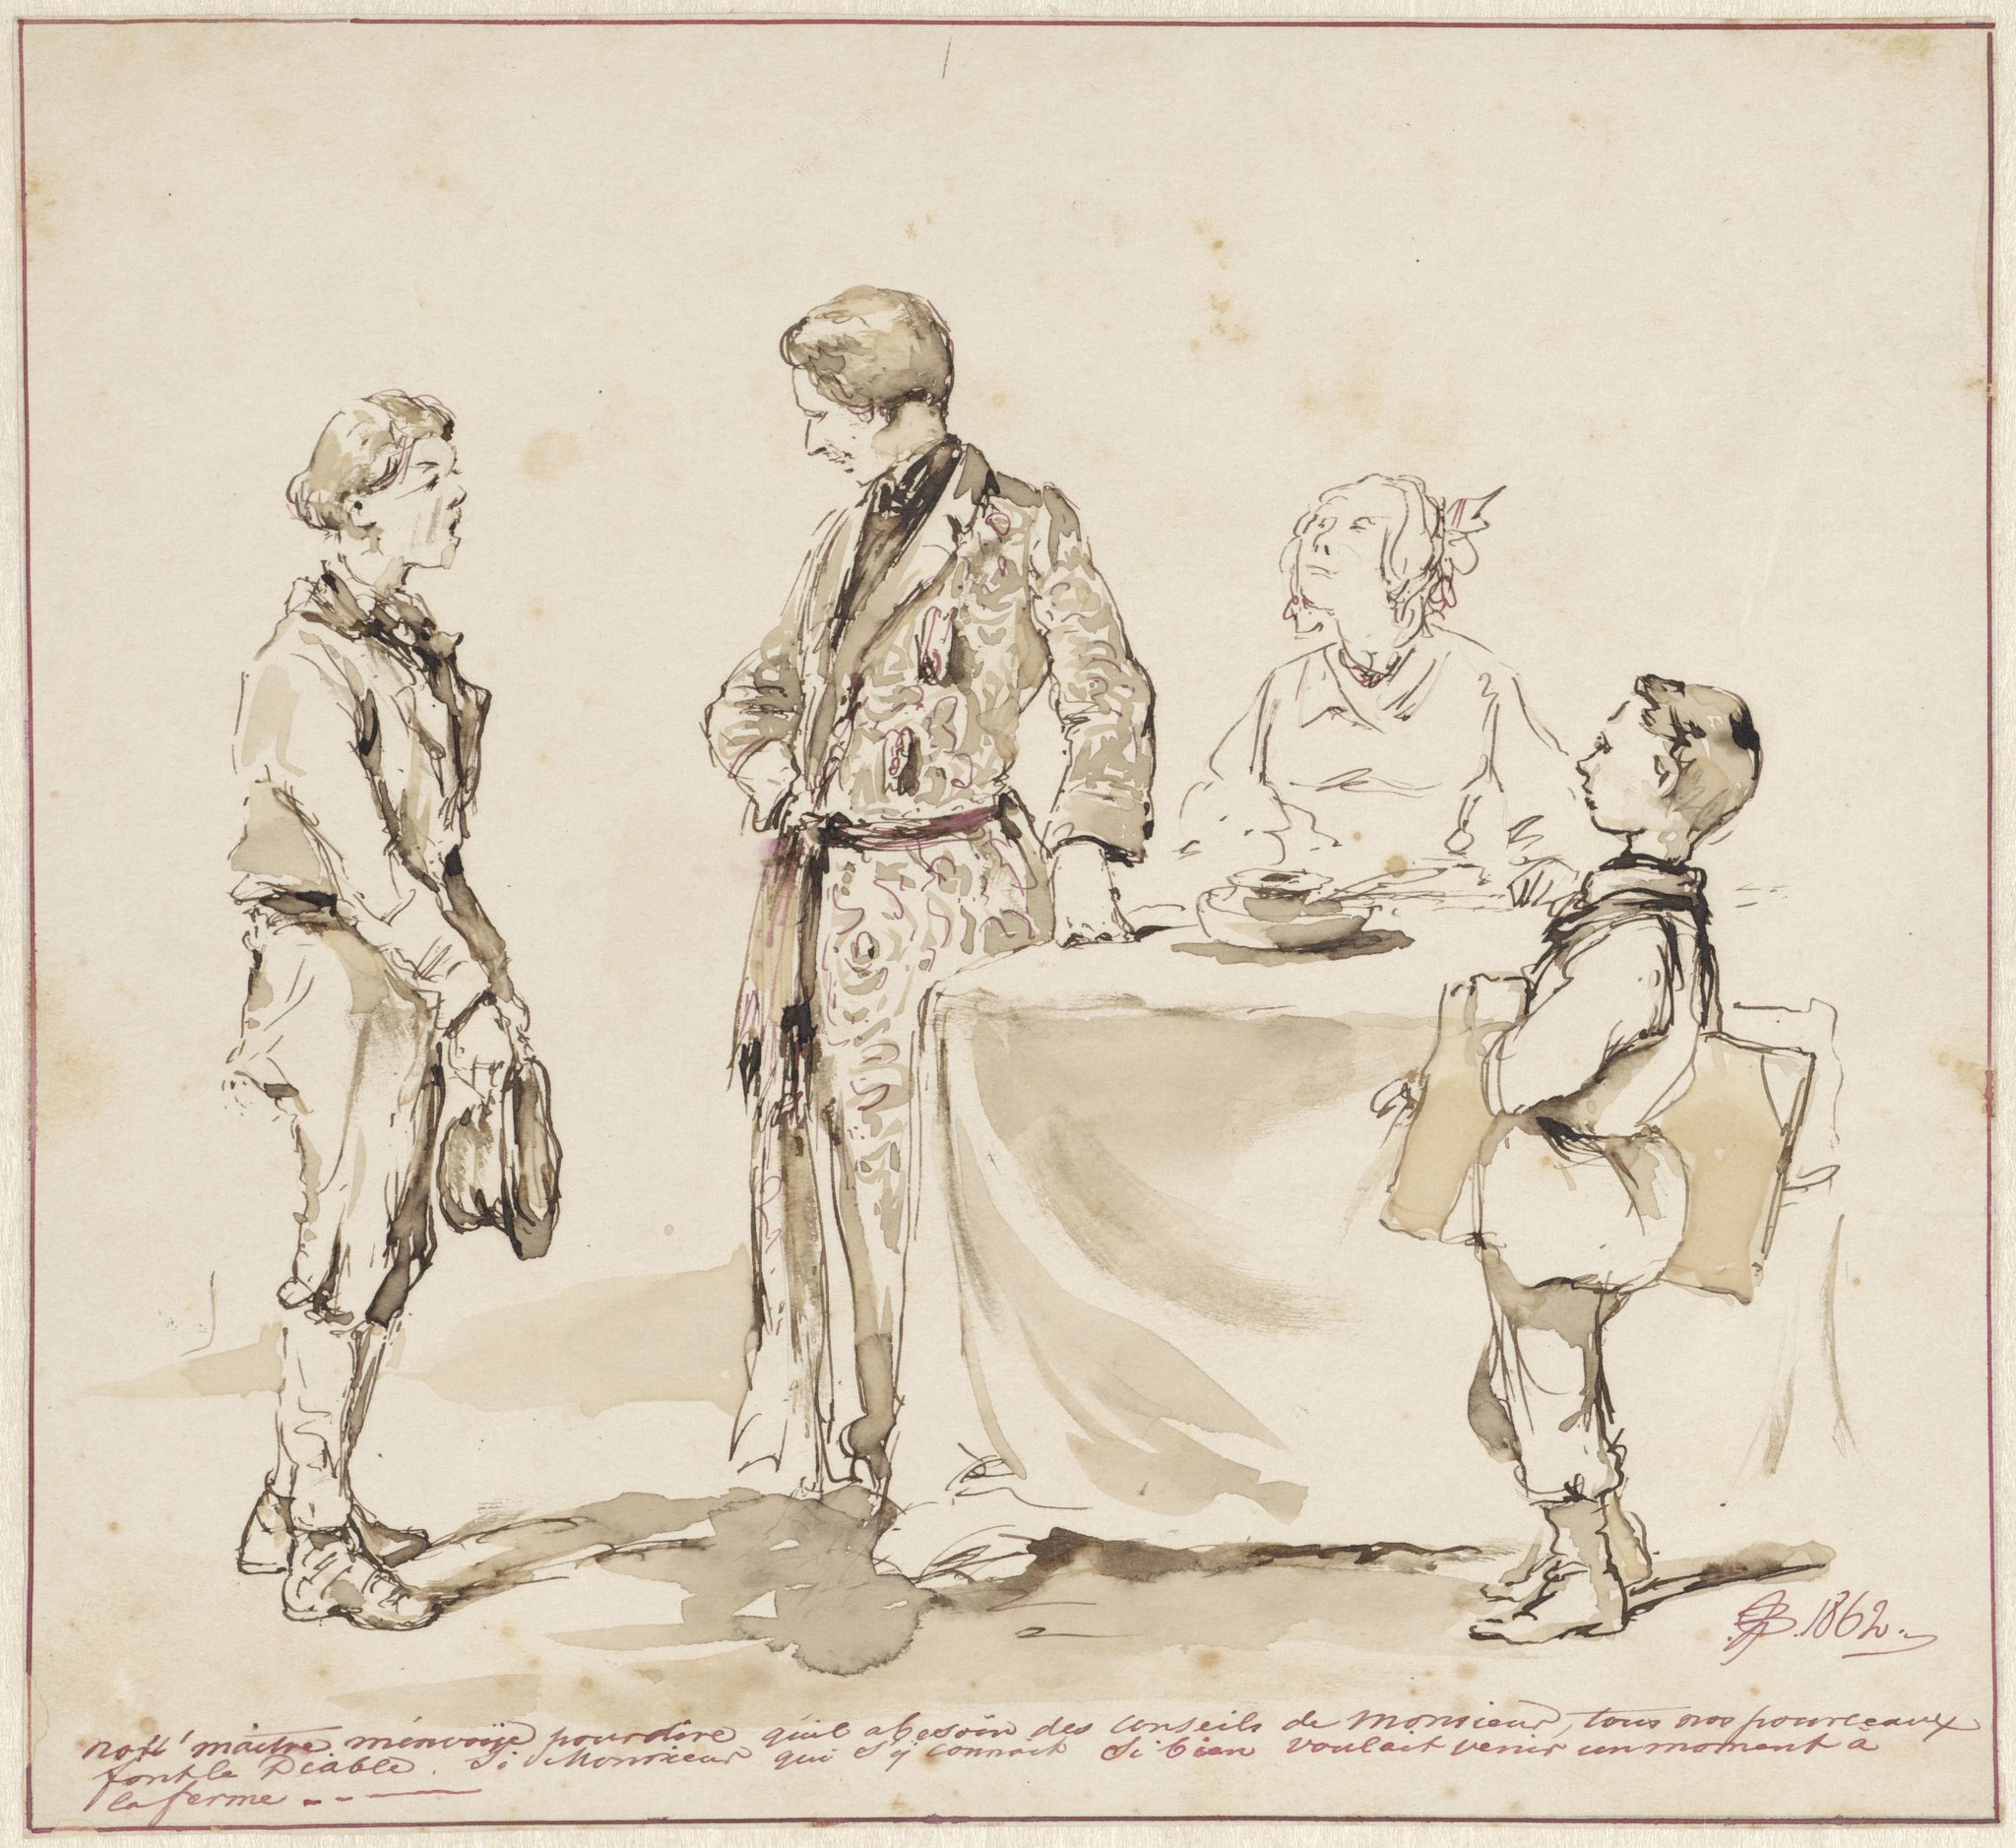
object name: drawing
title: Karikaturale scène met een boerenknaap bij een mondain gezin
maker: pieter van loon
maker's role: draughtsman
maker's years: 1801-1873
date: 1862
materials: ink, paper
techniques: brush, pen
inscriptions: inscription: ‘not' maitre m'envoije pour dire quil a besoin... [etc.]’